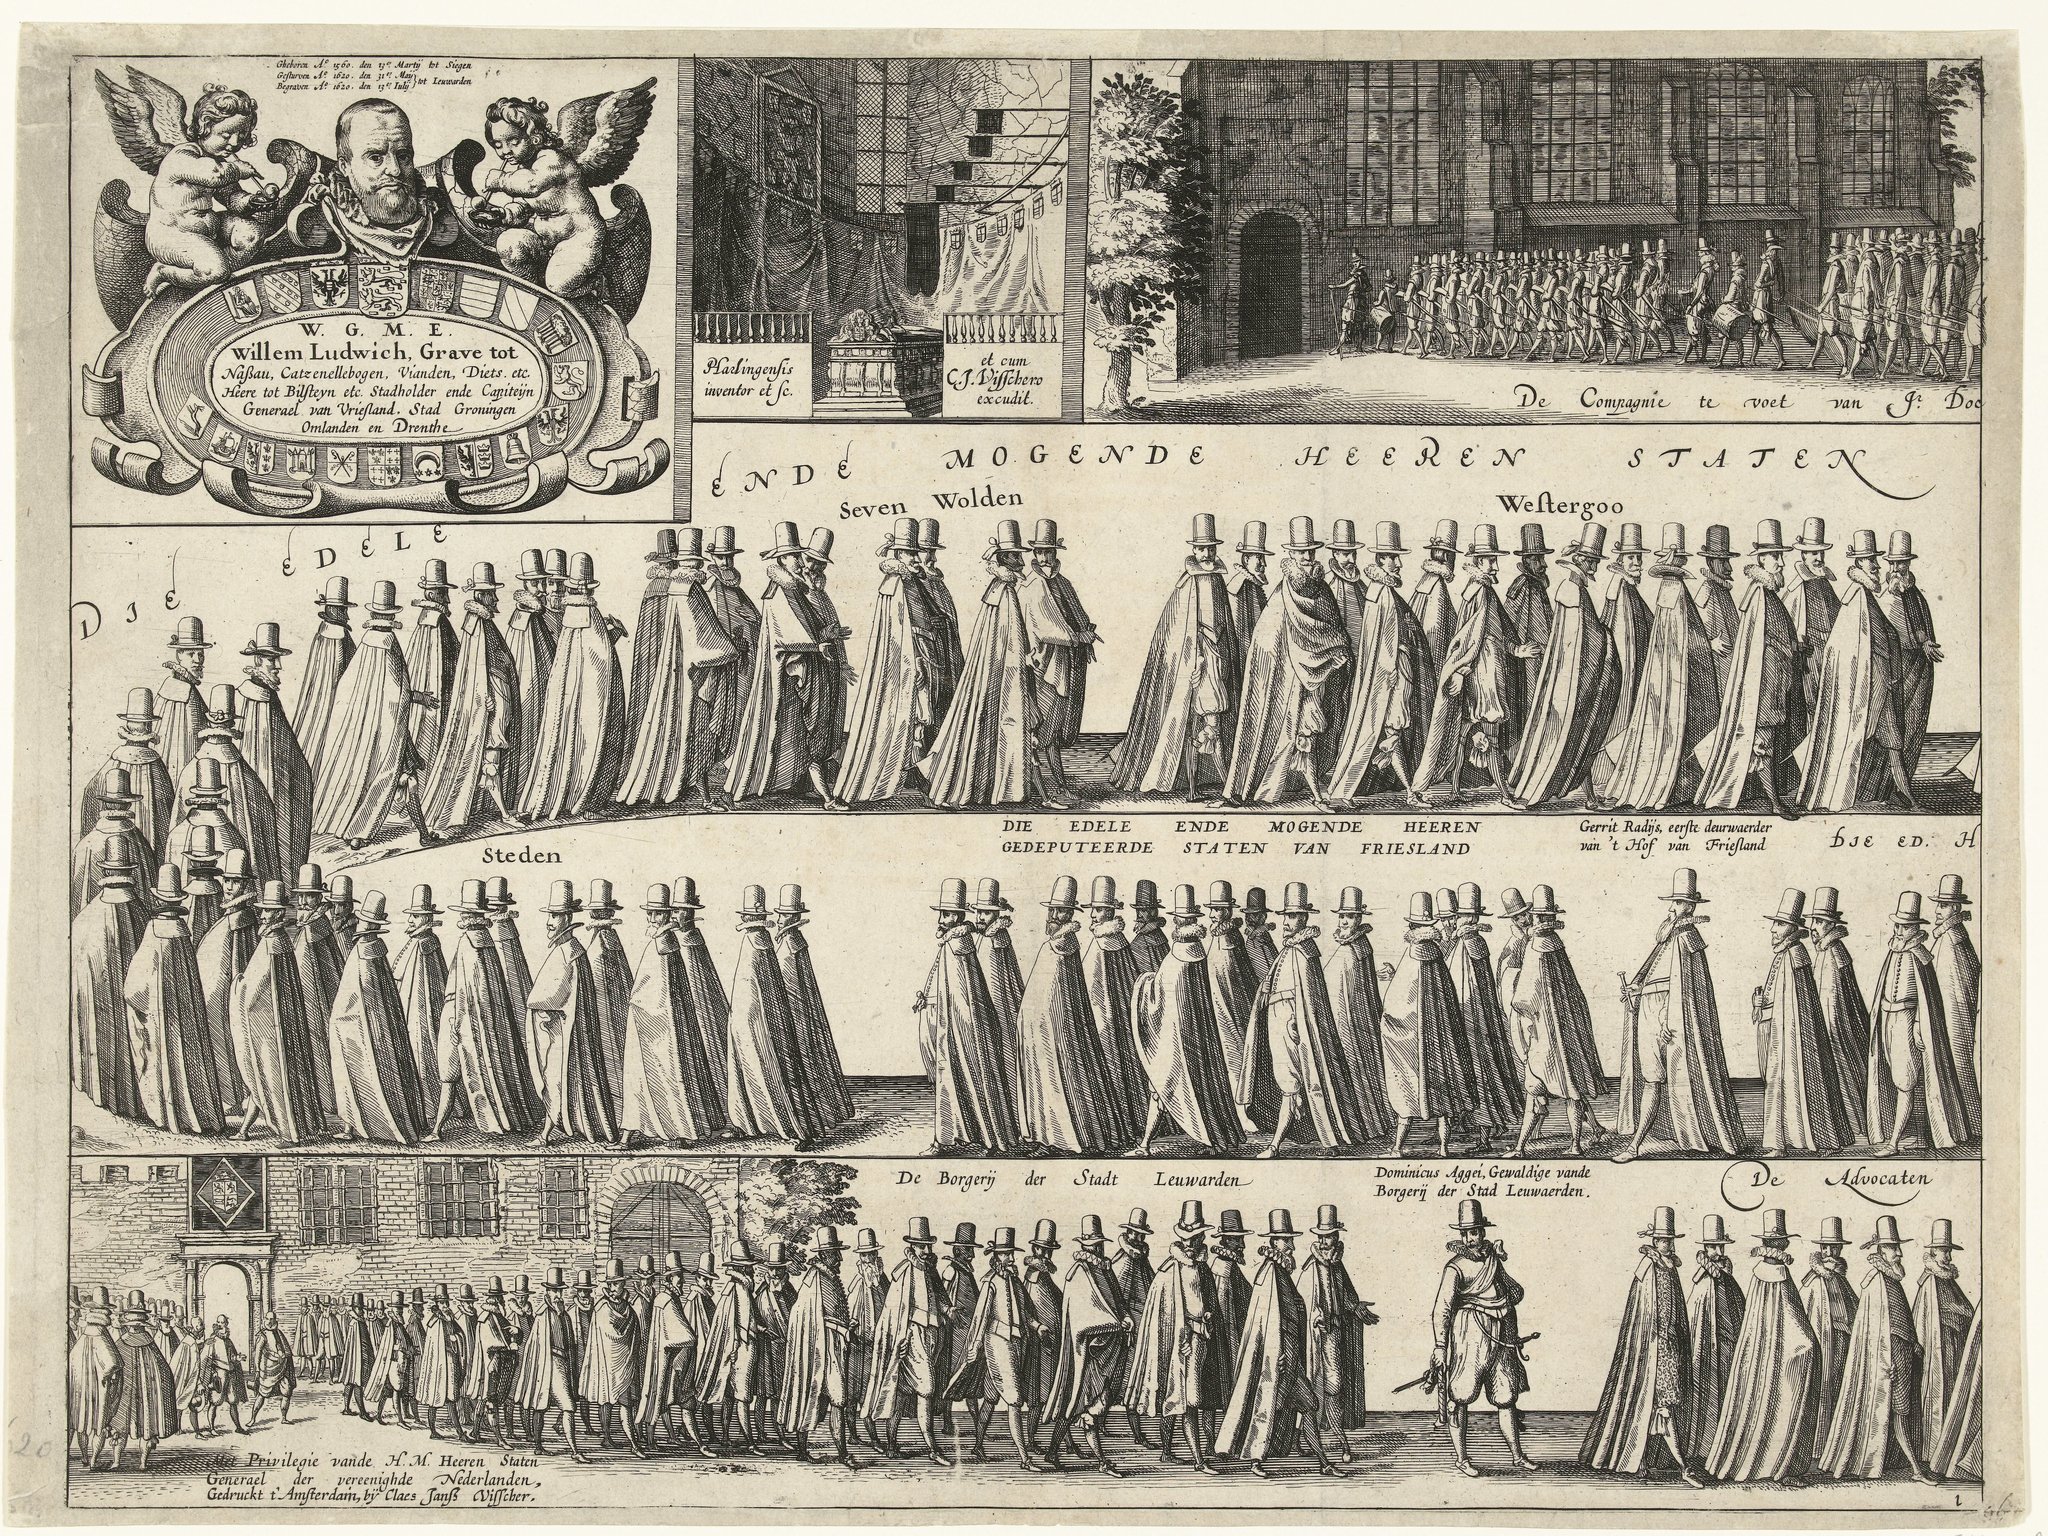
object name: print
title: Begrafenis van Willem Lodewijk, graaf van Nassau, in de Grote Kerk te Leeuwarden, 1620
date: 1620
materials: paper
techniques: engraving, etching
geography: northern netherlands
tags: willem lodewijk graaf van nassau-dillenburg, cortege, funeral procession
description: Begrafenis van Willem Lodewijk, graaf van Nassau, in de Grote Kerk te Leeuwarden op 13 juli 1620, blad 1. Blad met een portret van Willem Lodewijk met wapens en twee bellenblazende engelen, het graf in de kerk, het vertrek van de begrafenisstoet uit de Kanselarij, en de aankomst bij de Grote Kerk.